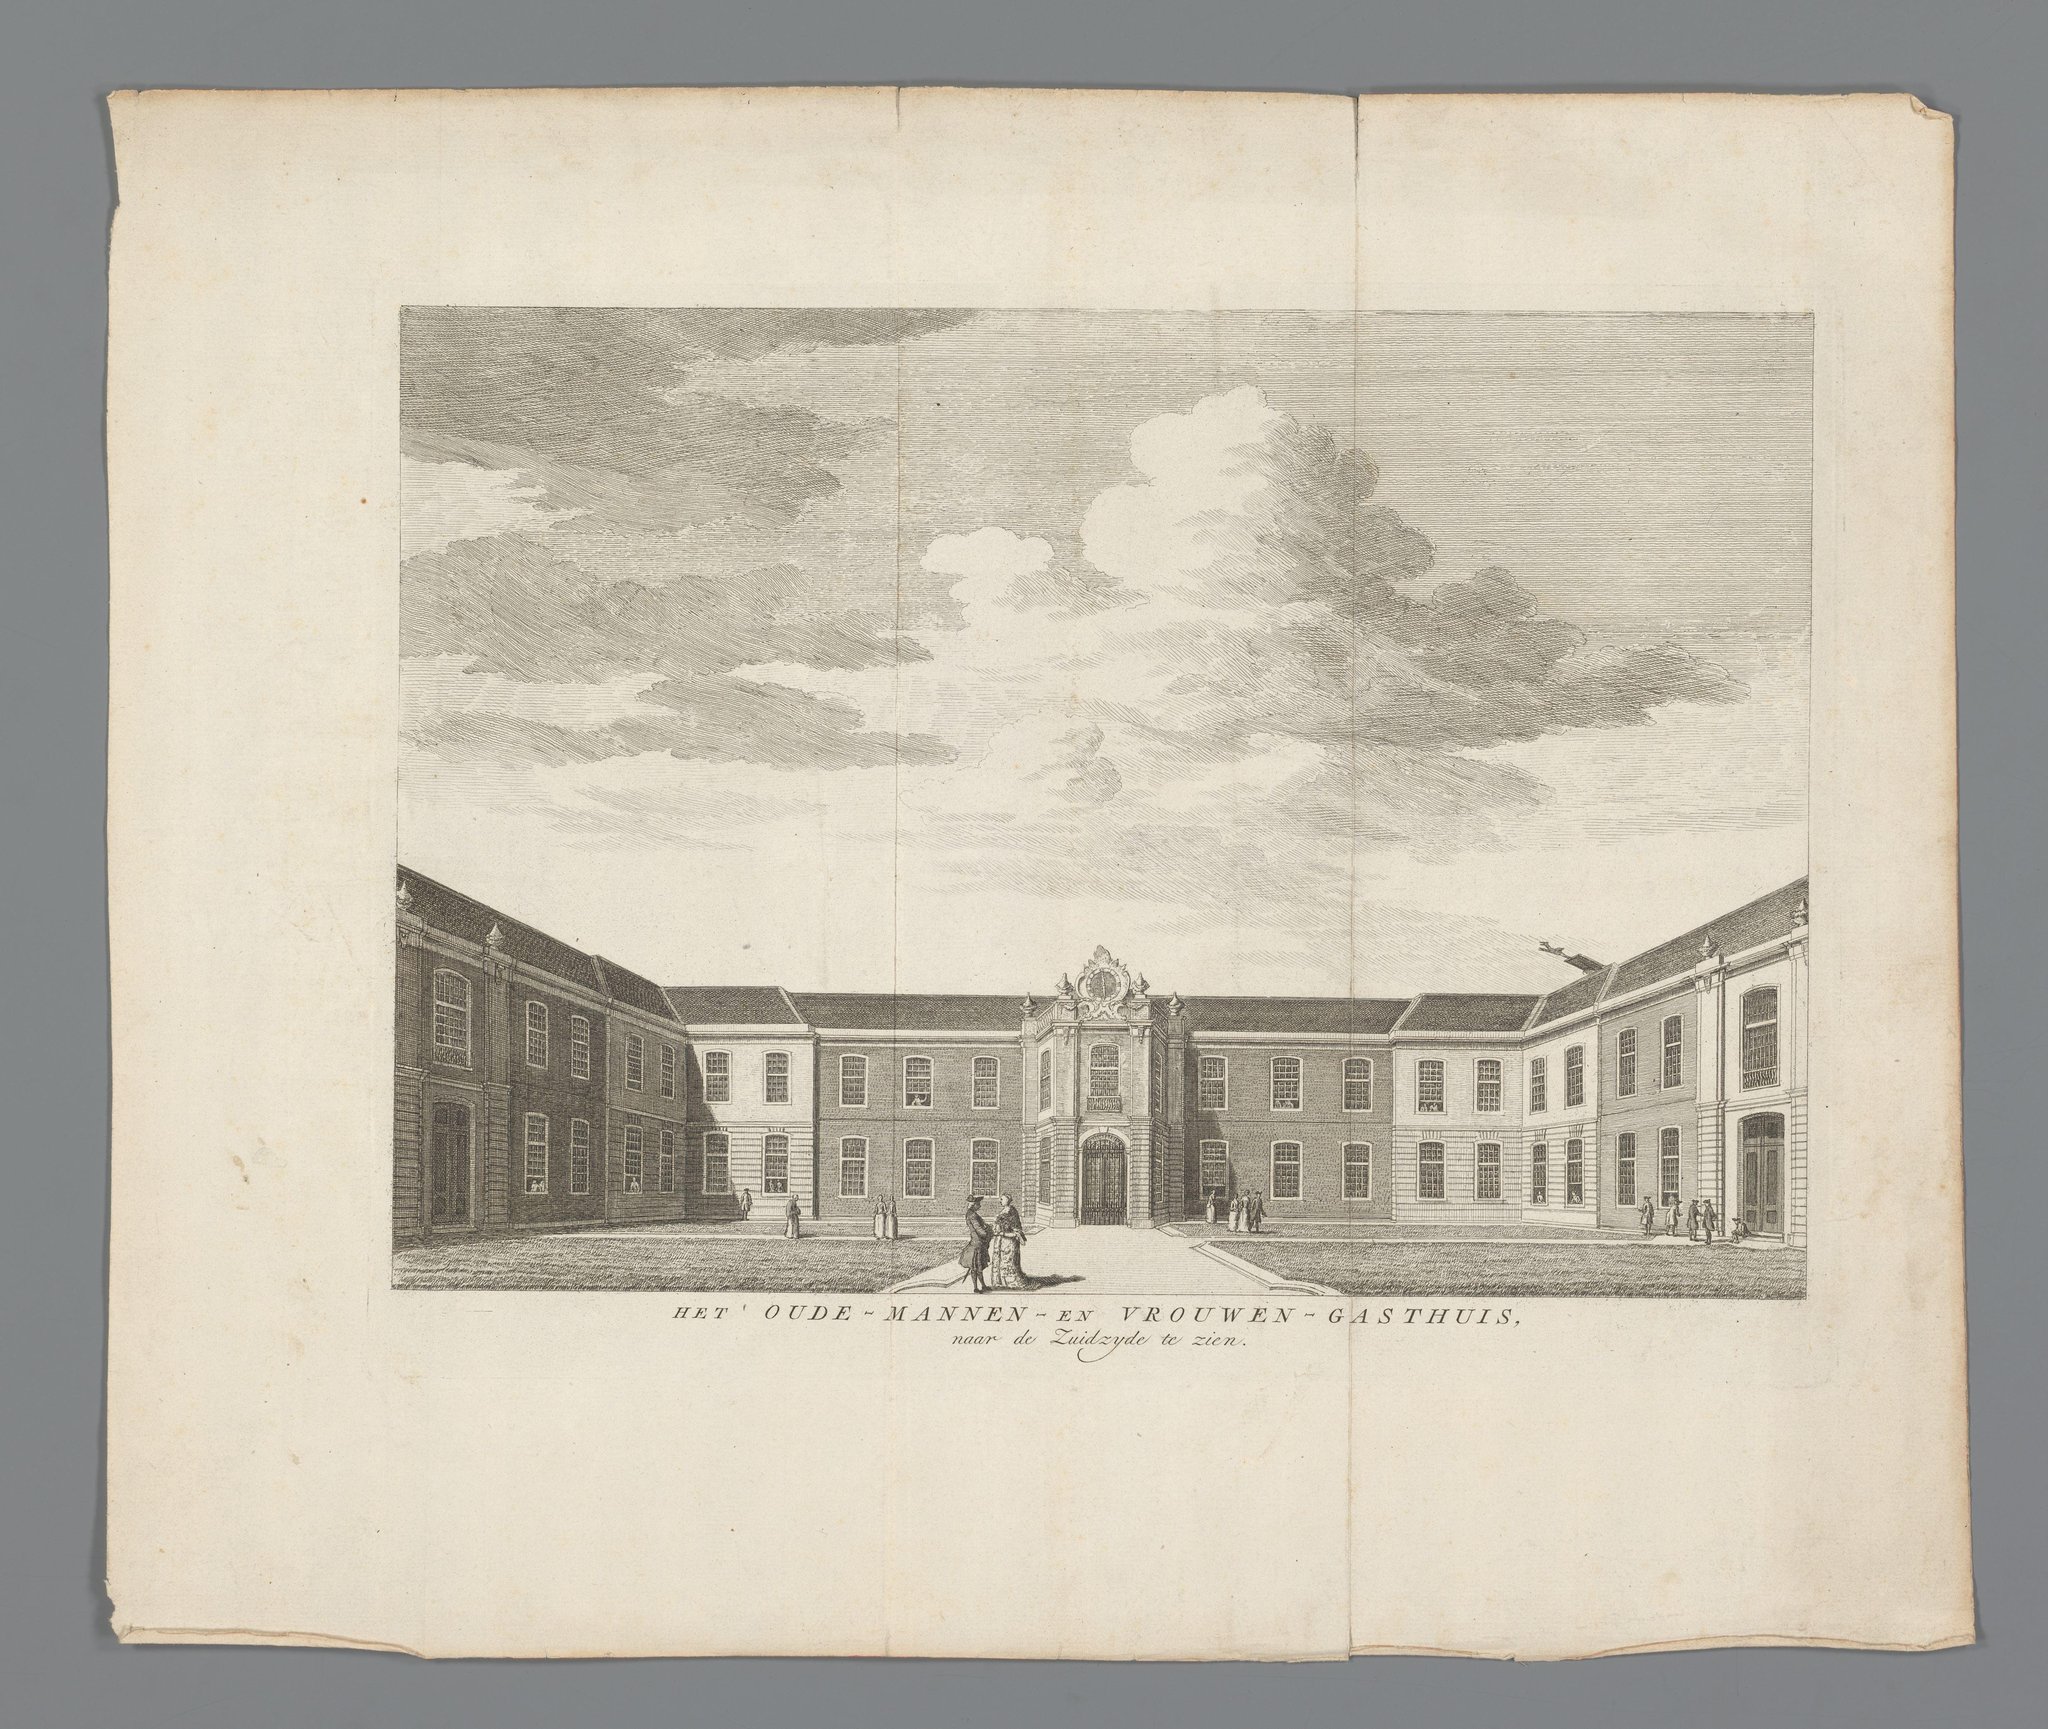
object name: print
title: Gezicht op het Oudemannenhuis te Amsterdam, gezien richting het zuiden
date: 1760-1767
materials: paper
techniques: etching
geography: amsterdam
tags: hospital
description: Prent uit: Wagenaar, Jan. Amsterdam, in zyne opkomst, aanwas, geschiedenissen, enz. 3 dln. Amsterdam: Isaak Tirion, 1760-1767.